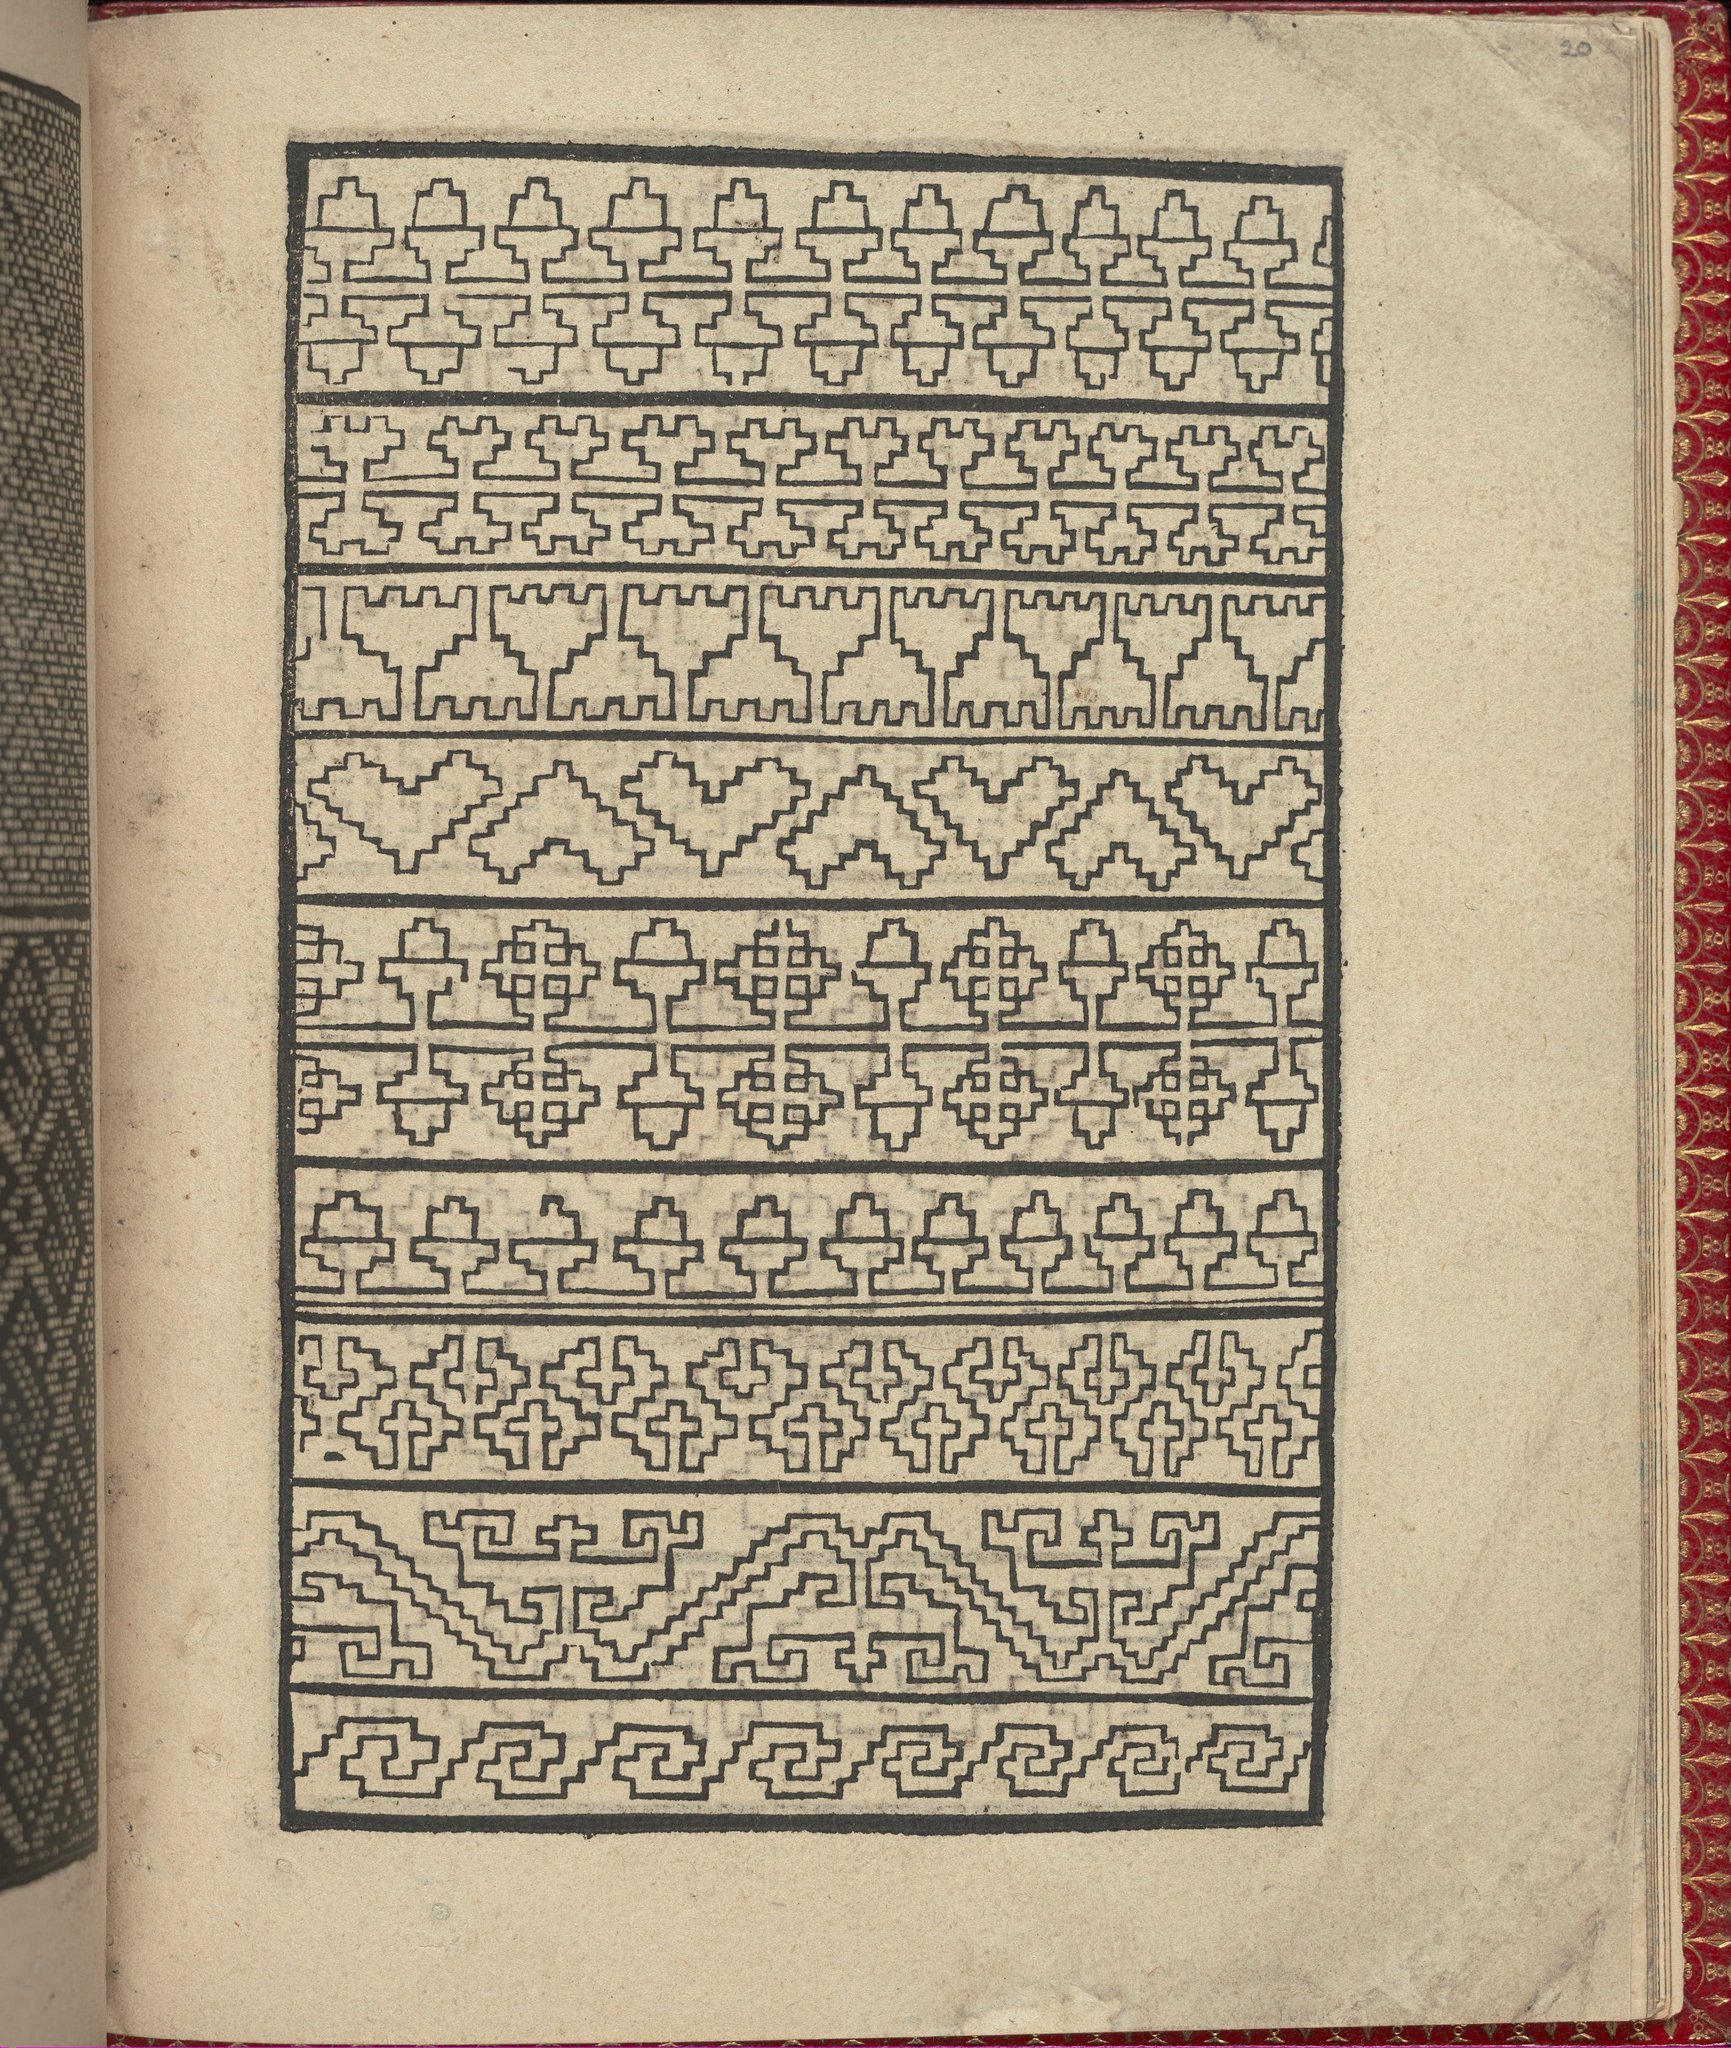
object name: book print ornament architecture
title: Ce est ung tractat de la noble art de leguille ascavoir ouvraiges de spaigne... page 20 (recto)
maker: willem vosterman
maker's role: printer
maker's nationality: netherlandish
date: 1527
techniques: woodcut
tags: ornament